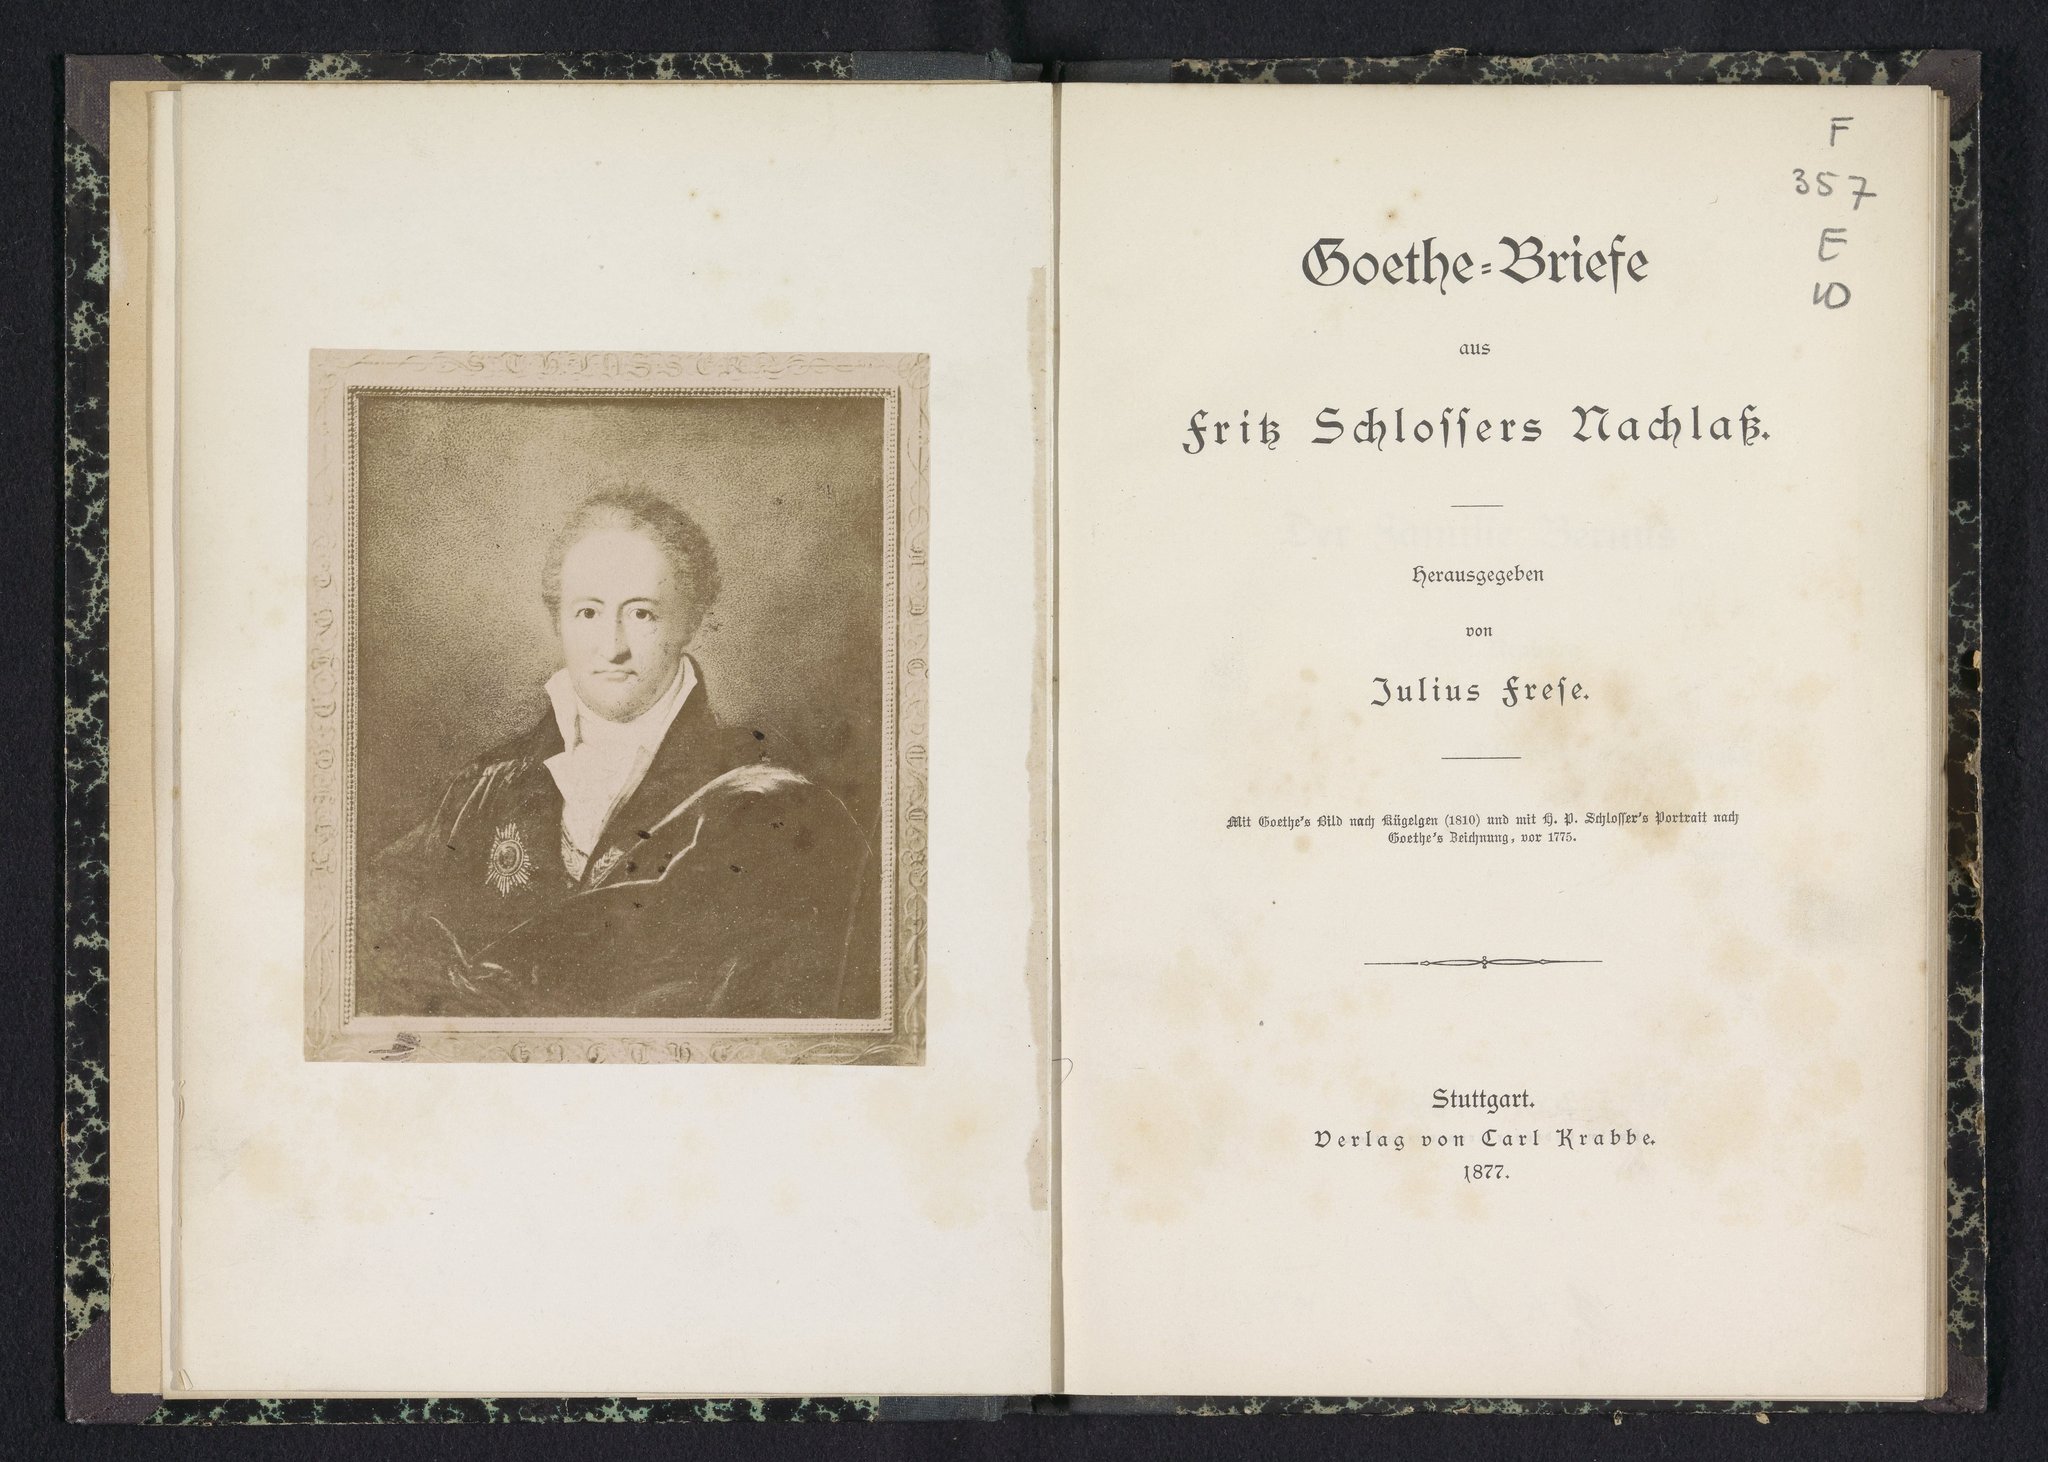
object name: reproduction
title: Fotoreproductie van een portret van Johann Wolfgang von Goethe door Franz Gerhard von Kügelgen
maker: Anonymous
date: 1867-1877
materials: photographic support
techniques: albumen print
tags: draughtsman, johann wolfgang von goethe, portrait of a writer